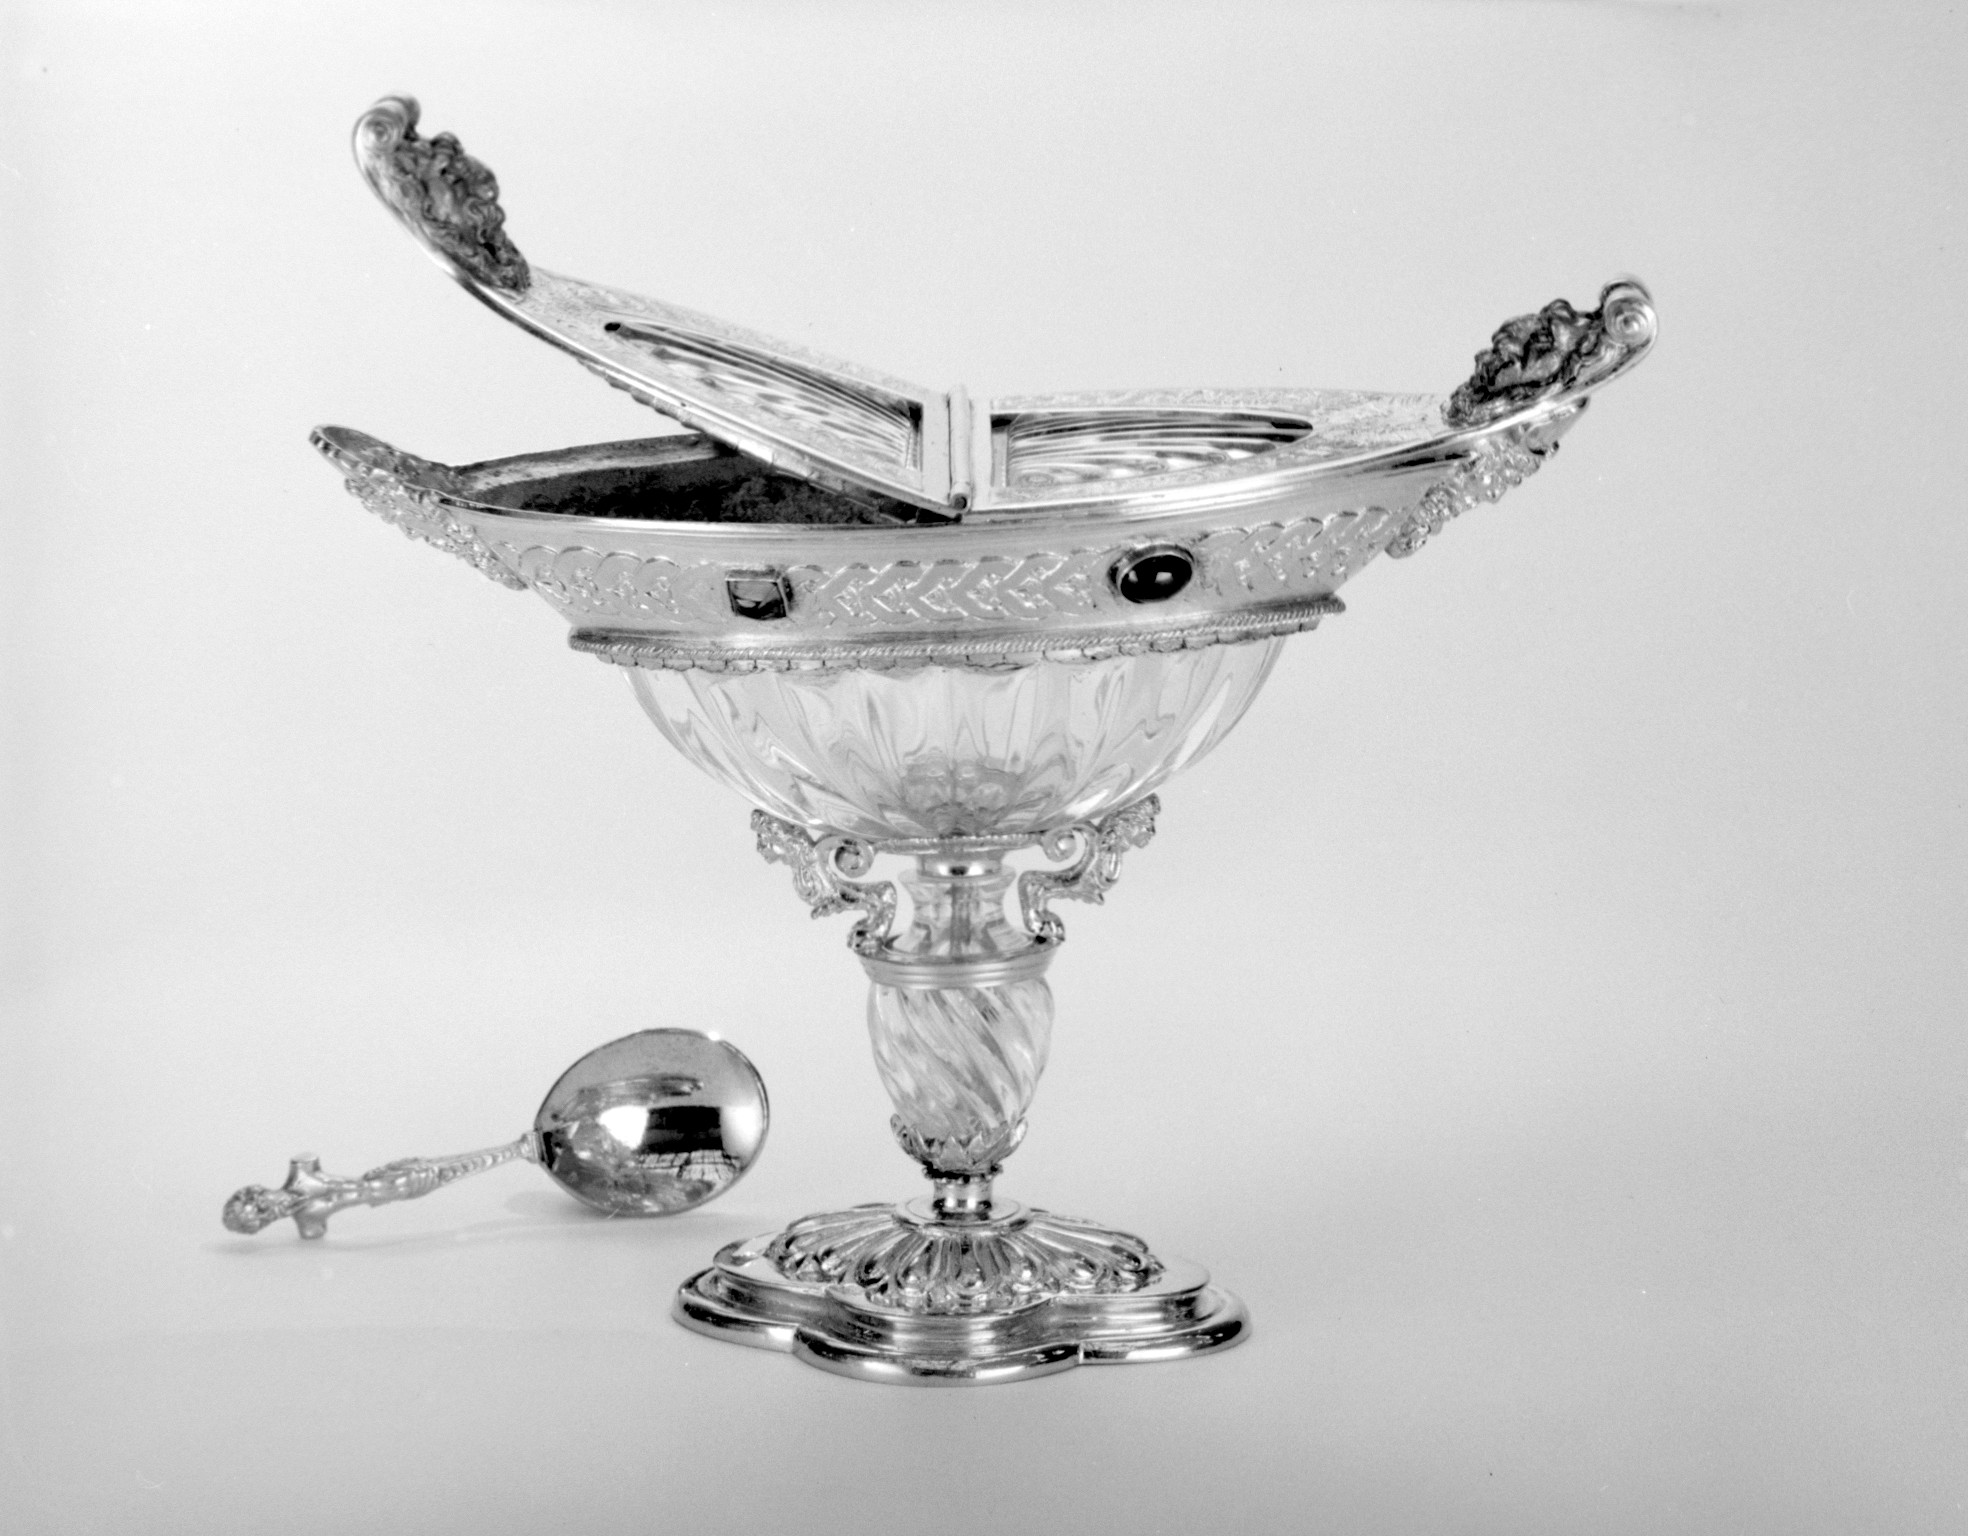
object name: incense holder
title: Incense holder (Navette)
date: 1801-1900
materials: amethyst, garnet, quartz, silver gilt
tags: faces